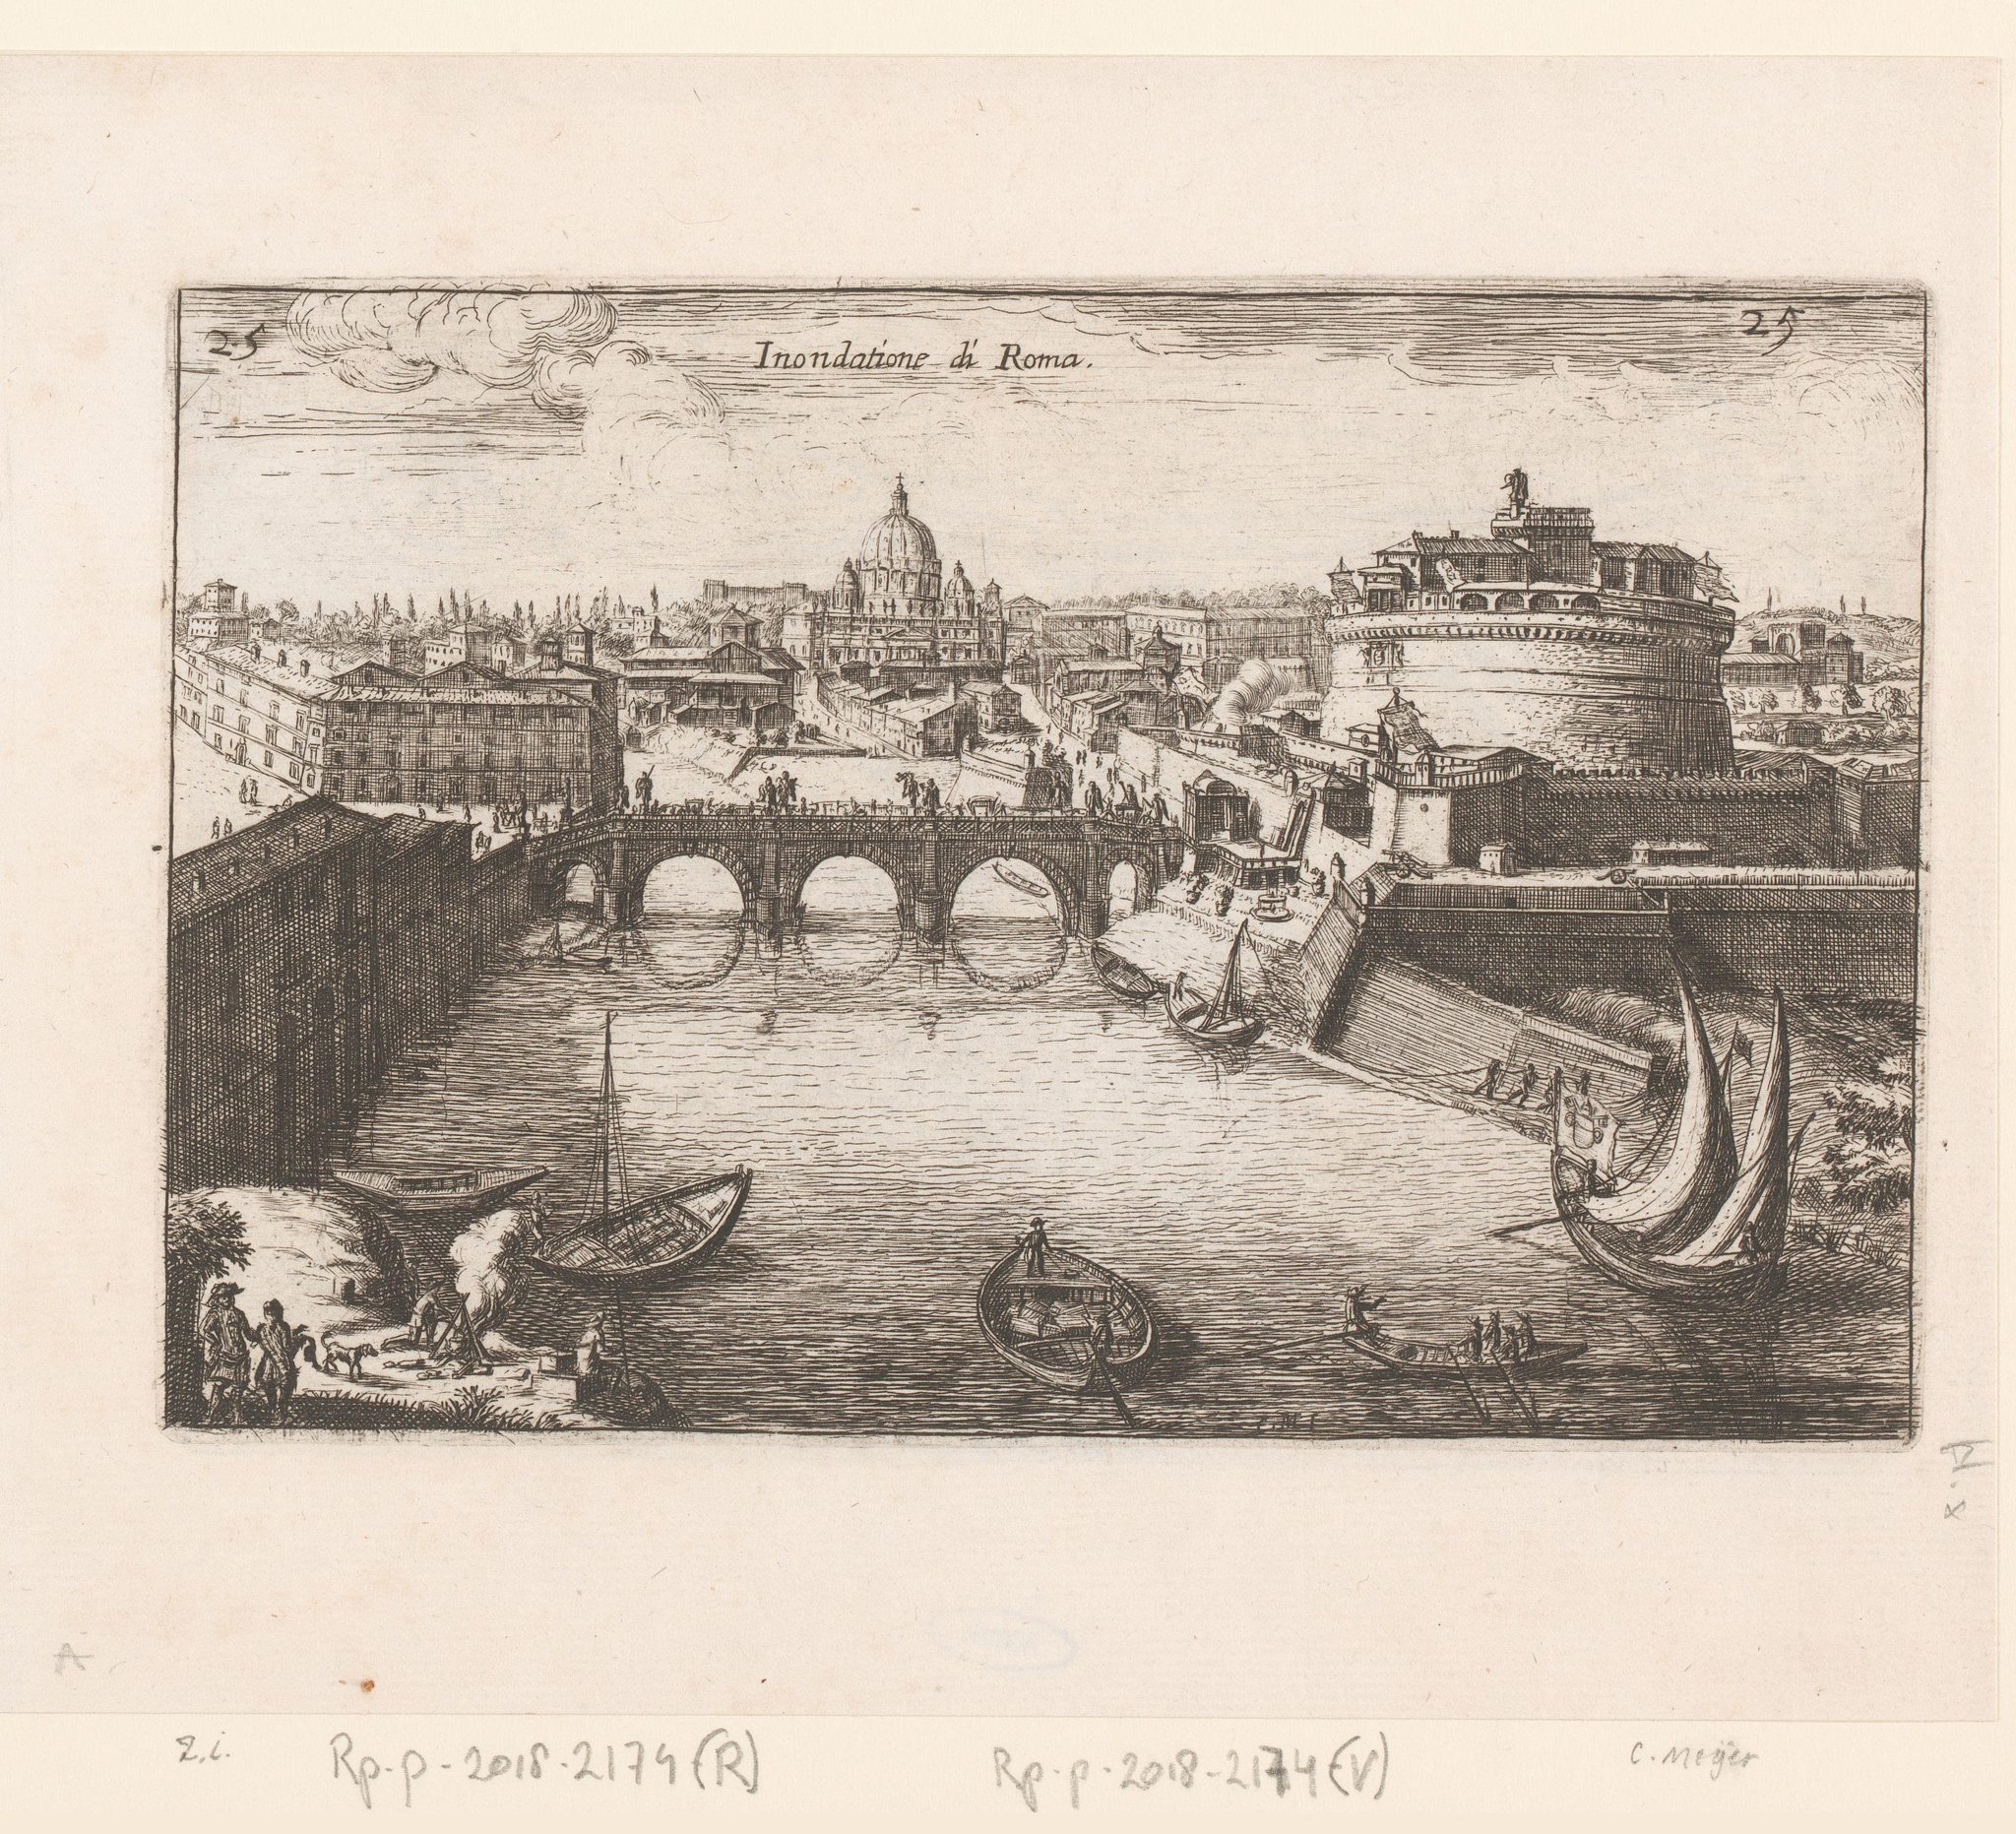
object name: print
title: Inondatione di Roma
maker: cornelis meijer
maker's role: draughtsman, print maker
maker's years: 1629-1701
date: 1639-1701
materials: paper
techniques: engraving, etching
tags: prospect of city, town panorama, silhouette of city, rome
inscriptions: collector's mark: Lugt 2228